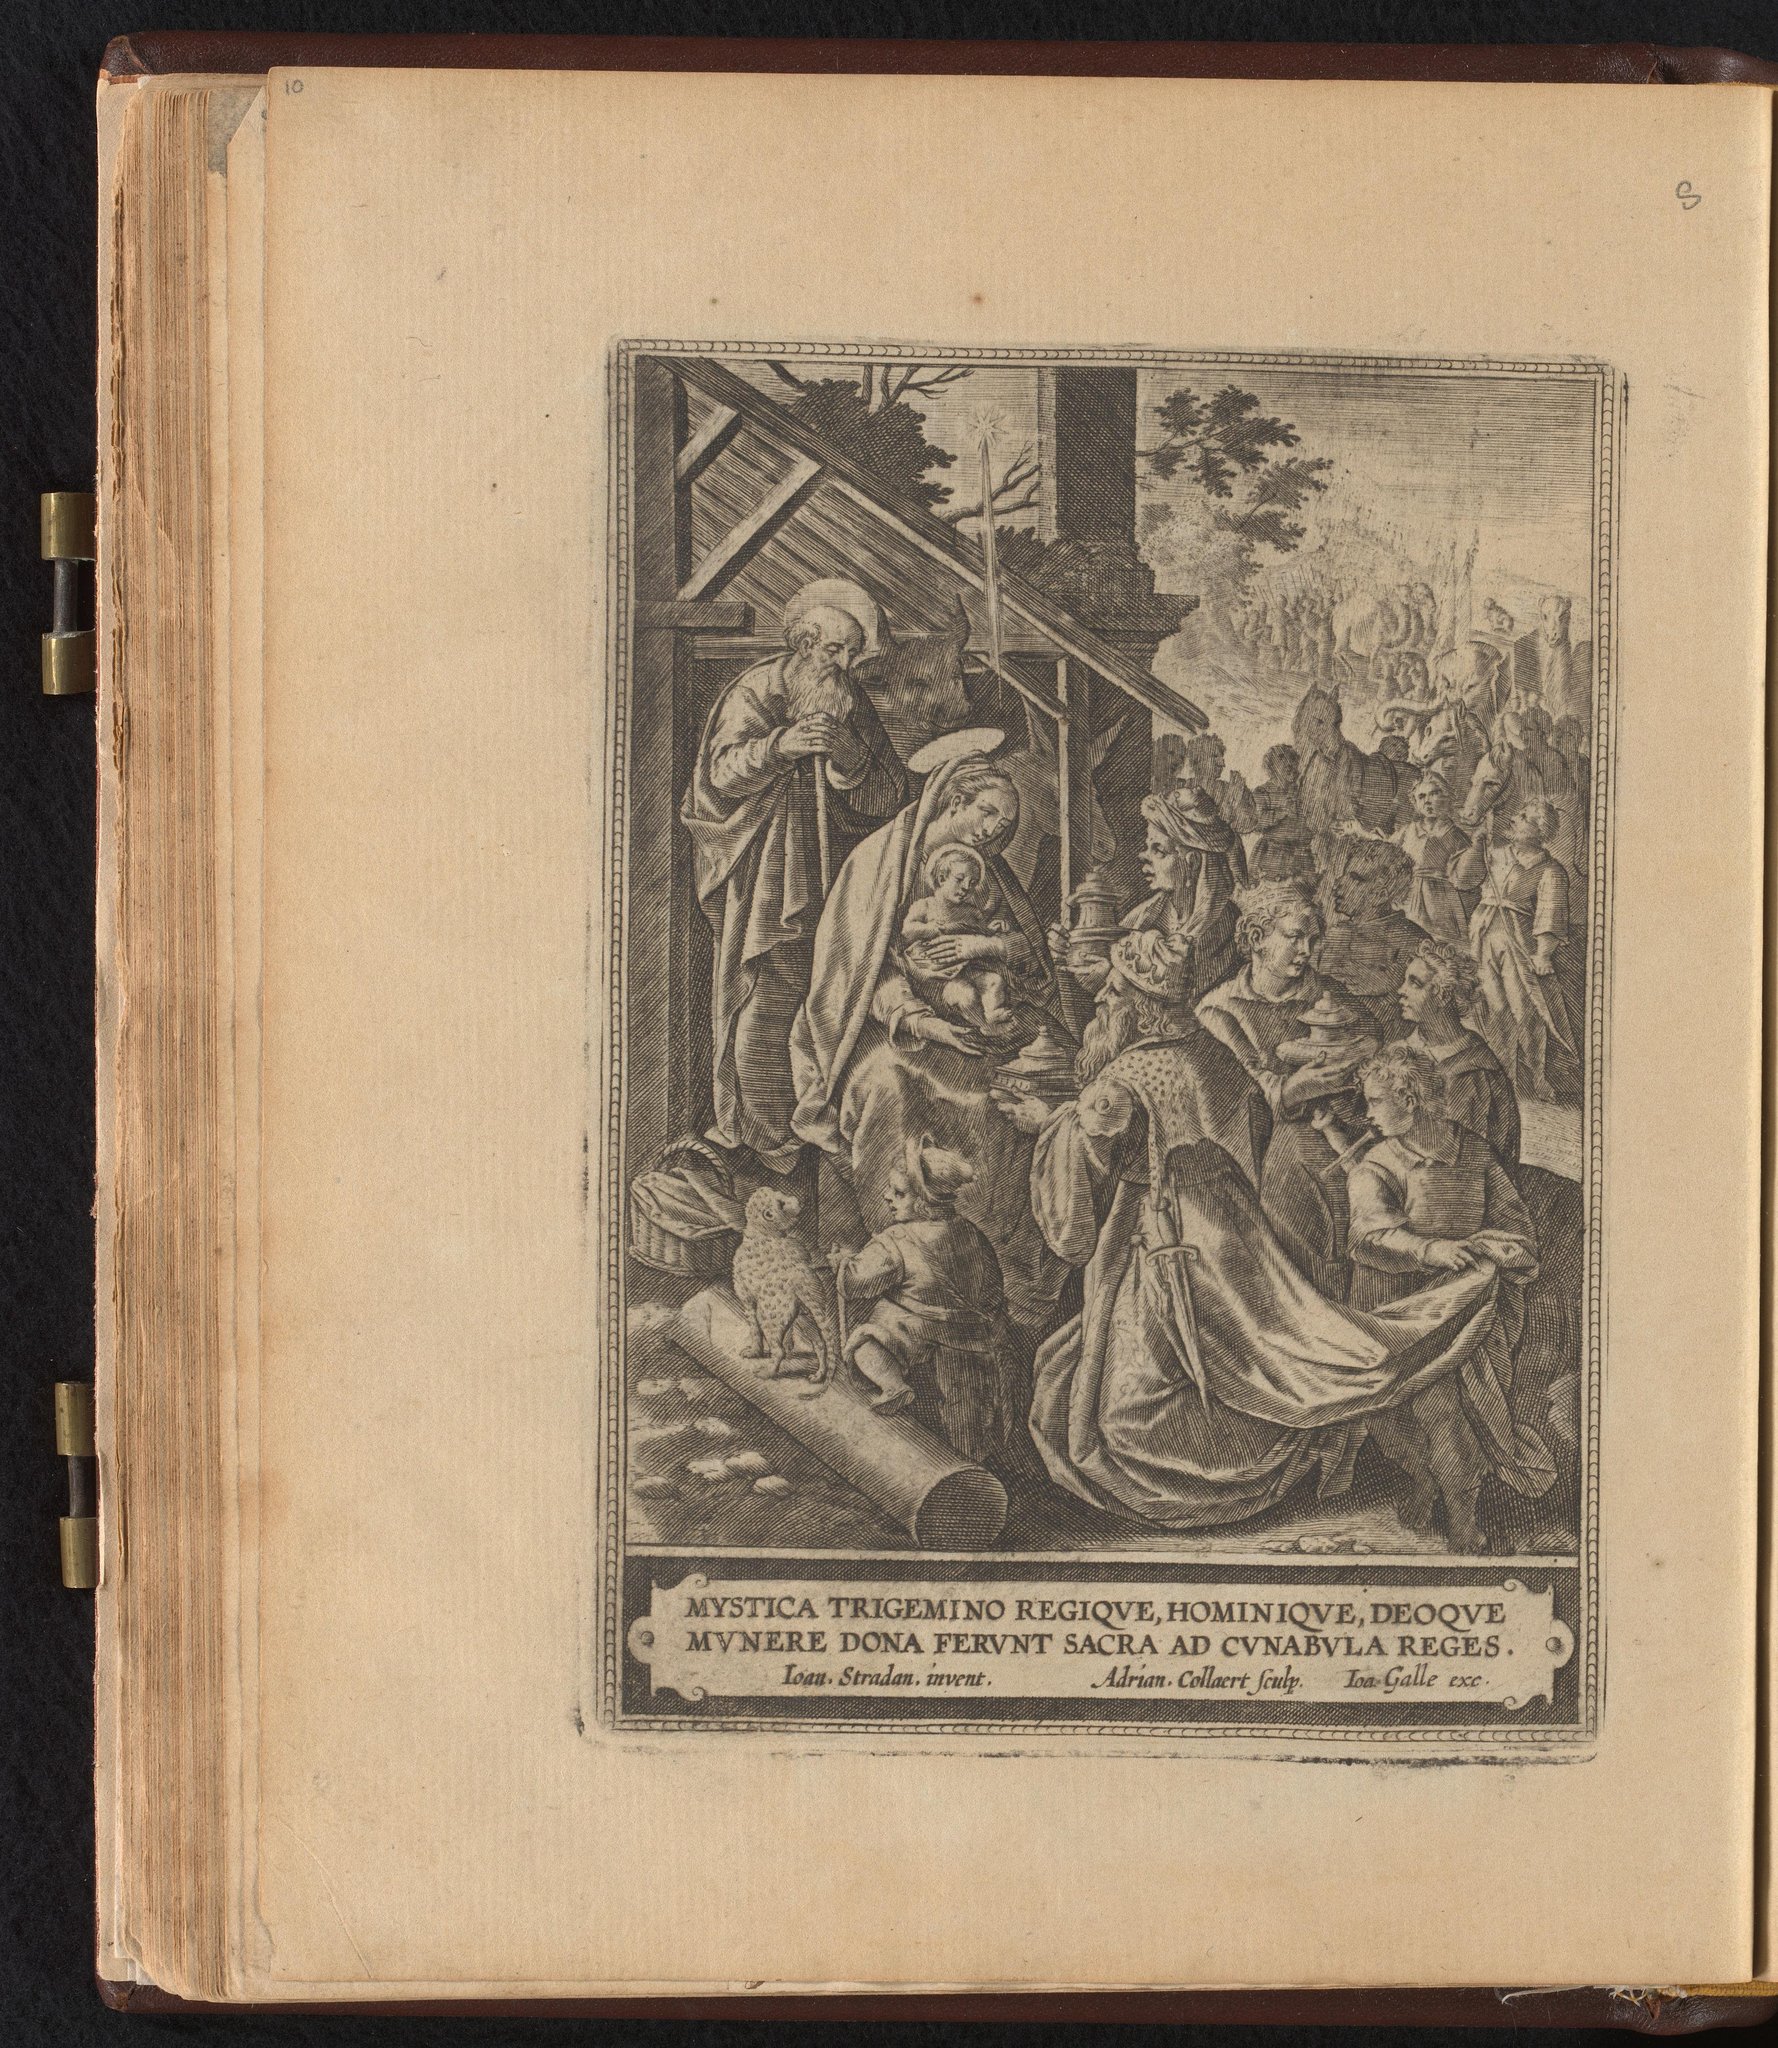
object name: print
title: Aanbidding der koningen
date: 1783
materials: paper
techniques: engraving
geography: antwerp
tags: adoration of the kings: the wise men present their gifts to the christ-child (gold, frankincense and myrrh)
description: Prent in: s.n. Aldernouwkeurigste verhandelinge der geschiedenissen van het Nieuw Testament (...). Antwerpen: Cornelis Marten Spanoghe, 1783, p. 16-17.